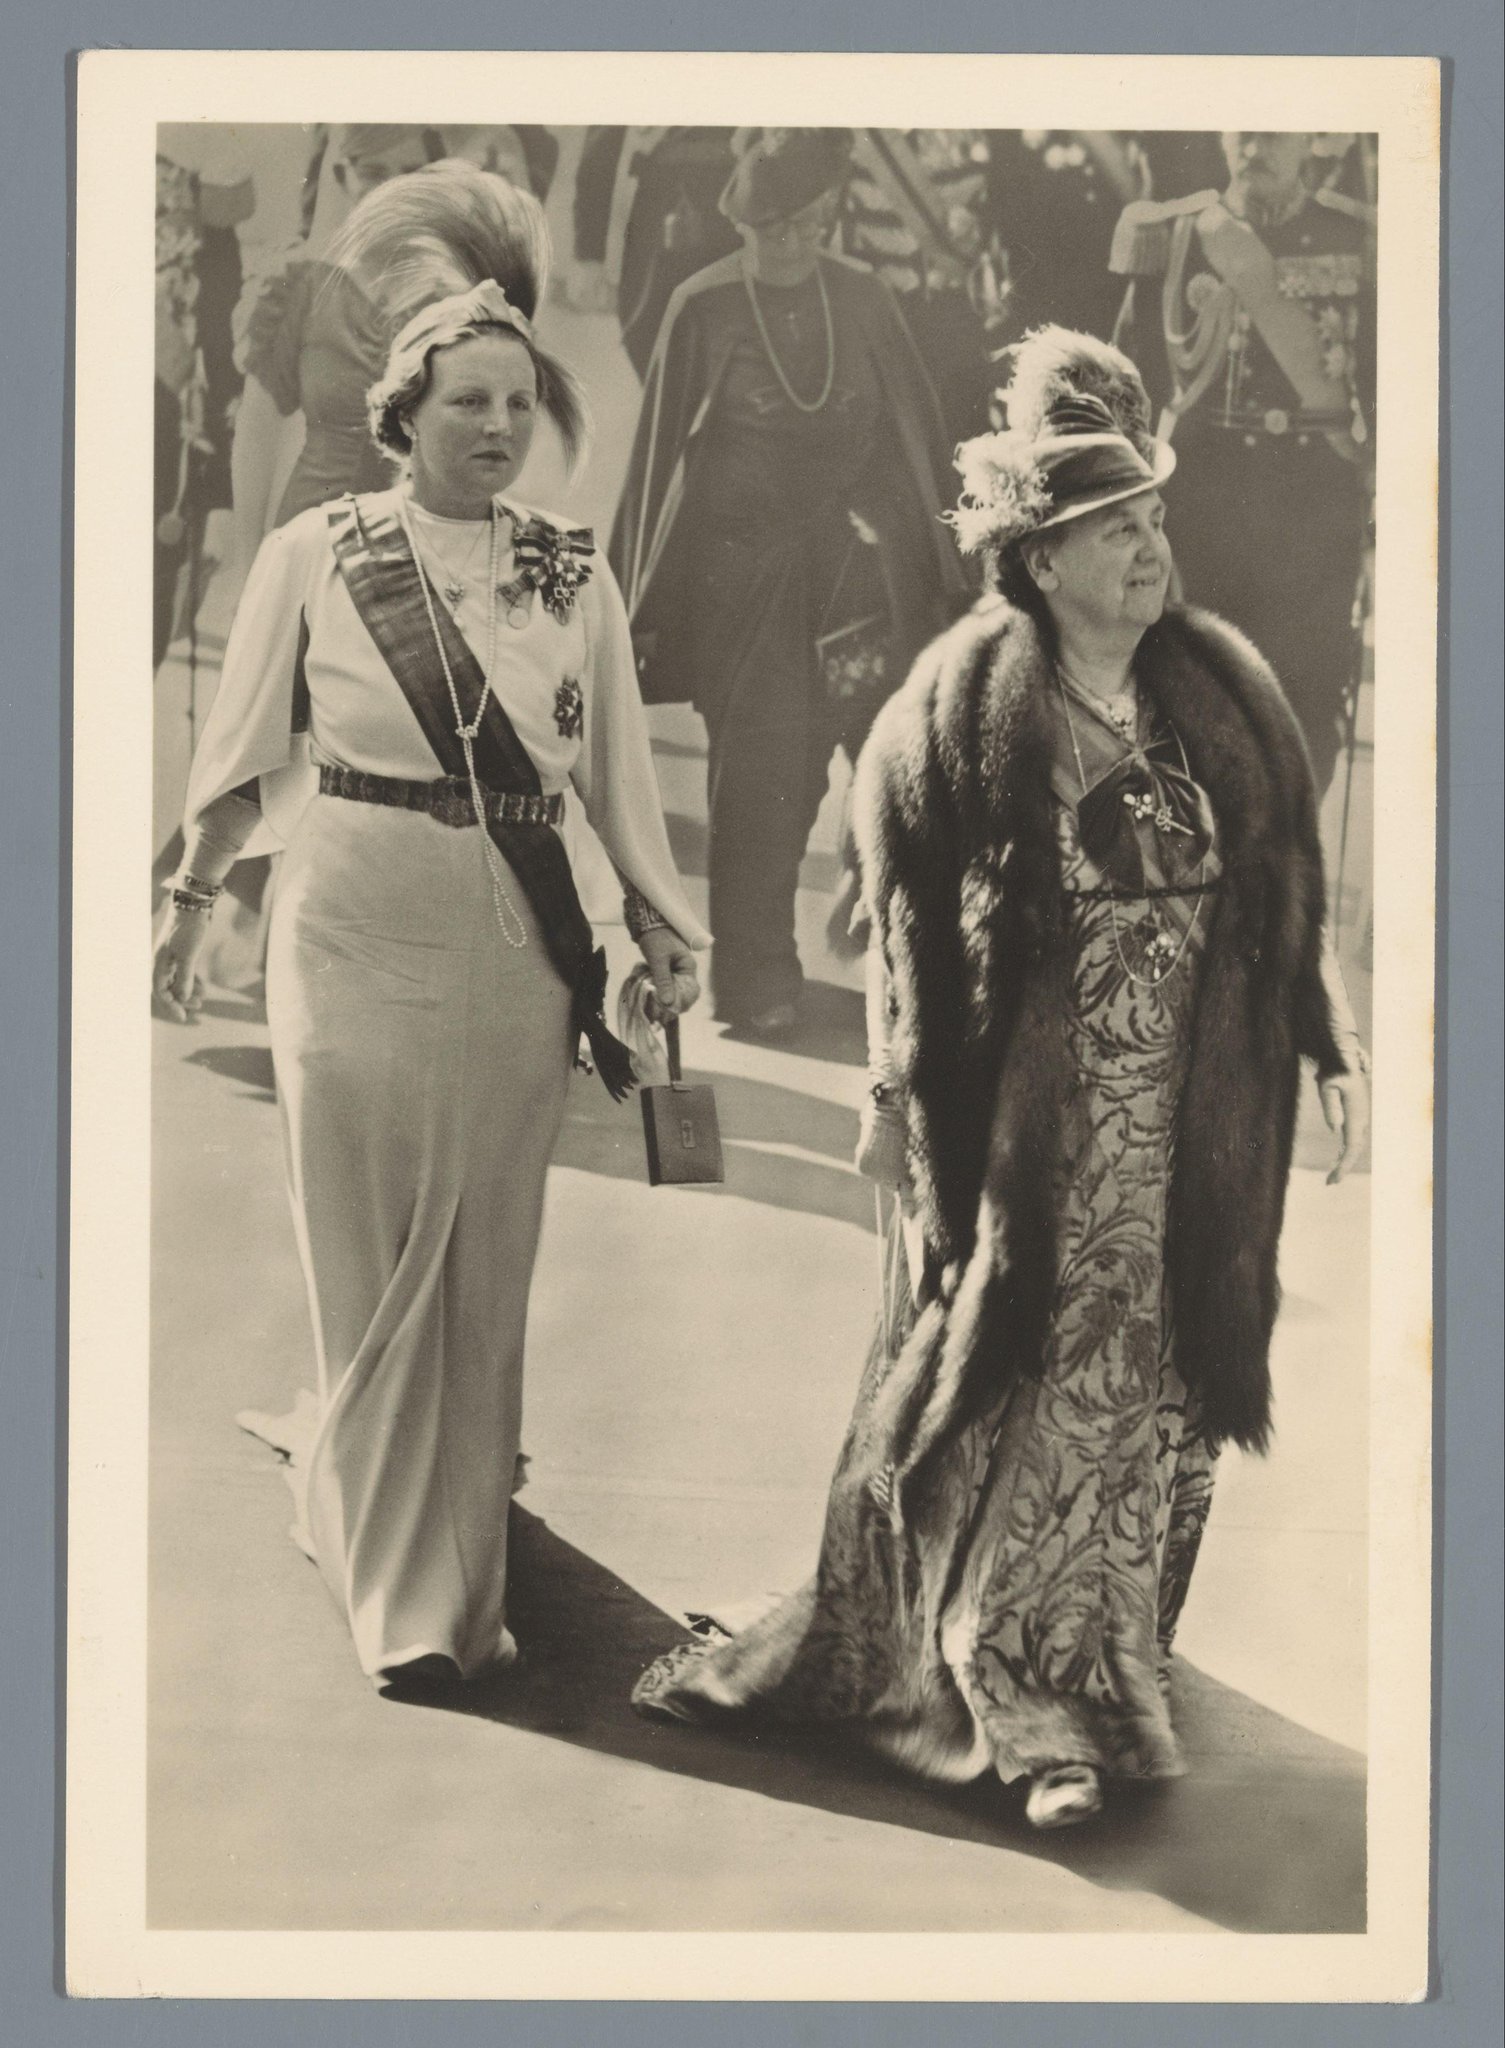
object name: photograph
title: Op weg naar de Nieuwe Kerk, te Amsterdam op 6 September 1938, voor de herdenkingsbijeenkomst van het 40- jarig regeeringsjubileum van H.M. de koningin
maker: Anonymous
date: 1938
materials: photographic support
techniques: gelatin silver print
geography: amsterdam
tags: print maker, wilhelmina of the netherlands, juliana of the netherlands, crown princess, queen